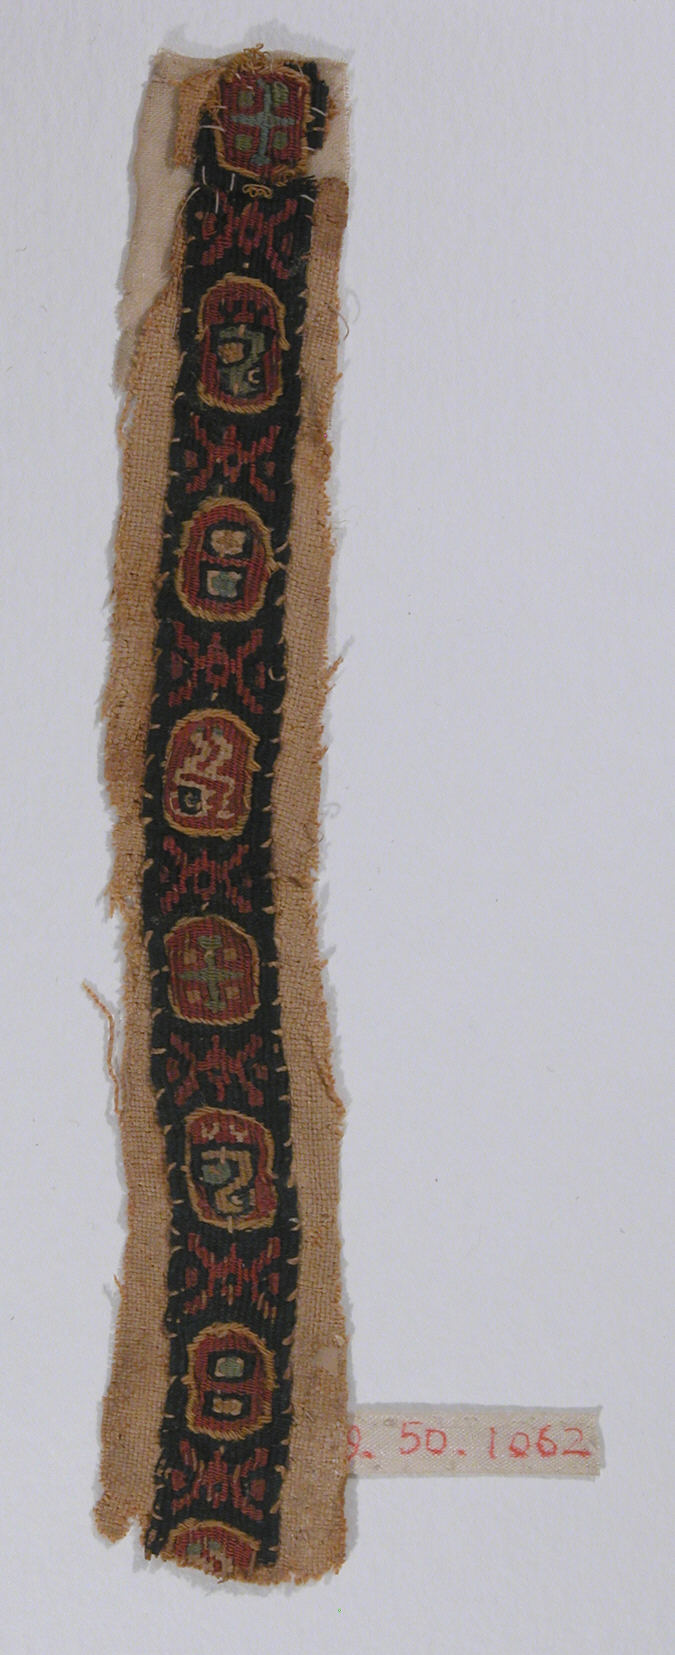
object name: band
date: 501-700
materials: linen, wool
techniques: weave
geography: egypt